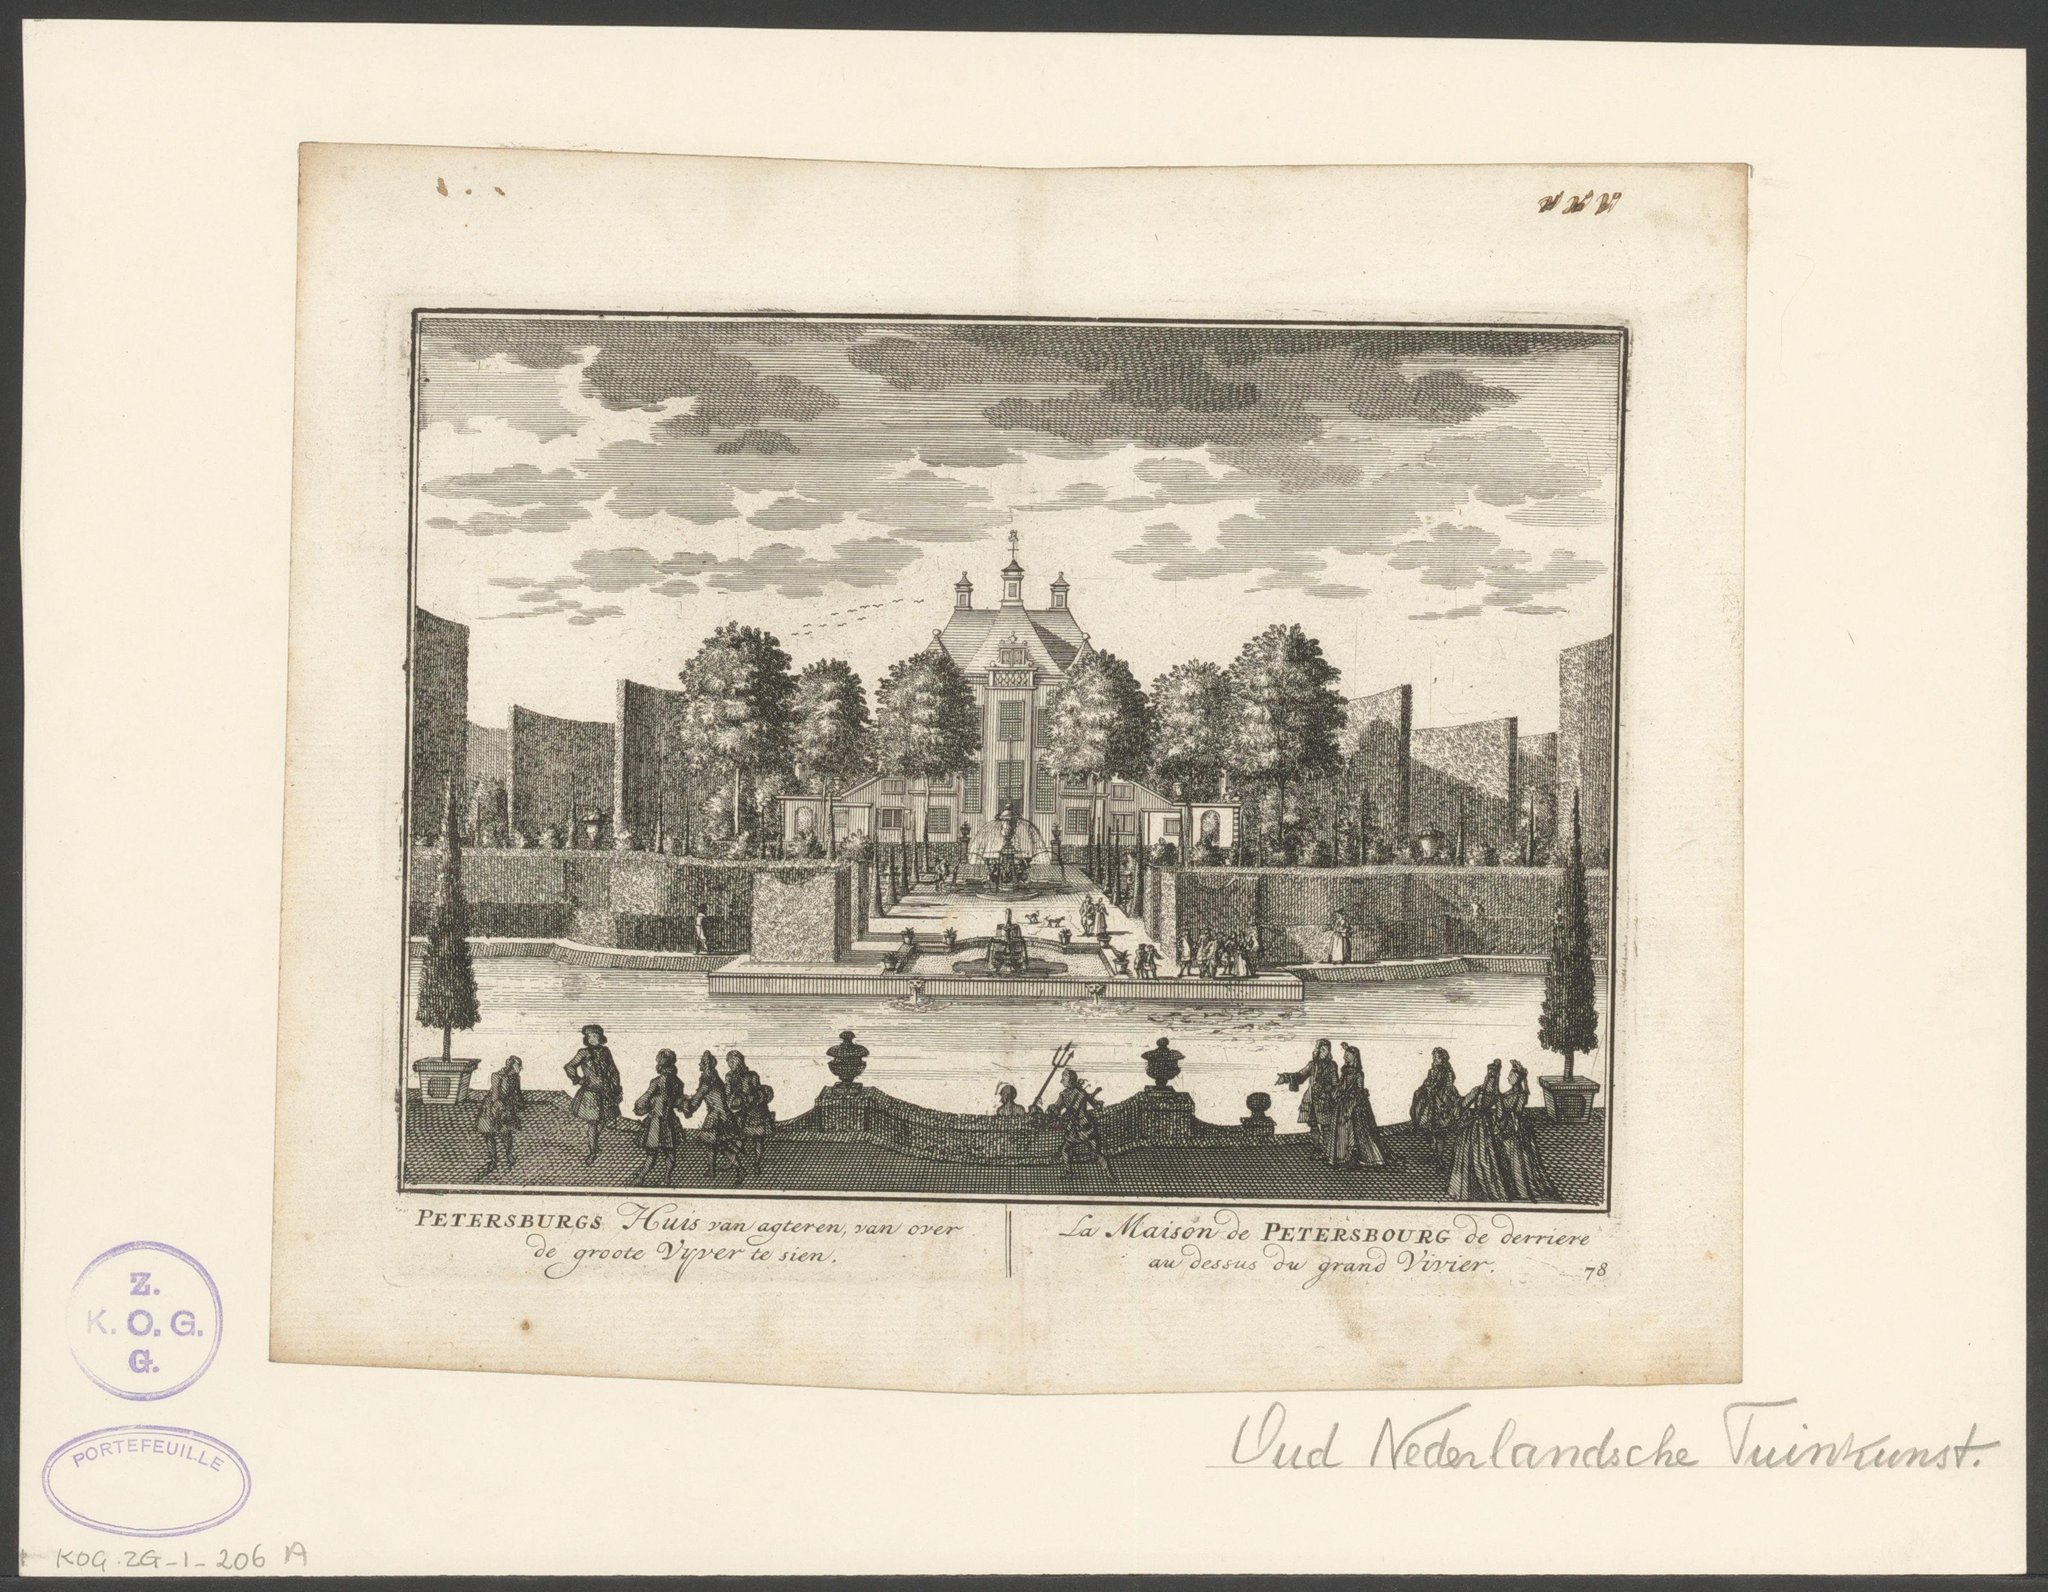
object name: print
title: Petersburgs Huis van agteren, van over de groote Vijver te sien / La Maison de Petersbourg de derriere au dessus du grand Vivier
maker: daniël stopendaal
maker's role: print maker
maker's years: 1672-1726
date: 1719-1790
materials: paper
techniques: engraving, etching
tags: french or architectonic garden; formal garden, country-house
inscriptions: stamp, collector's mark: Lugt 1641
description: Prent voor het eerst gebruikt in: Leth, Andries de. De zegepraalende Vecht, vertoonende verscheidene gesichten van lustplaatsen, heeren huysen en dorpen, beginnende van Uitrecht en met Muyden besluytende (...). Amsterdam: Weduwe Nicolaus Visscher, 1719. Prent mogelijk uit: Brouërius van Nidek, Matthaeus. De Vechtstroom, van Utrecht tot Muiden (...). Amsterdam: H. Gartman, W. Vermandel en J.W. Smit, 1790.